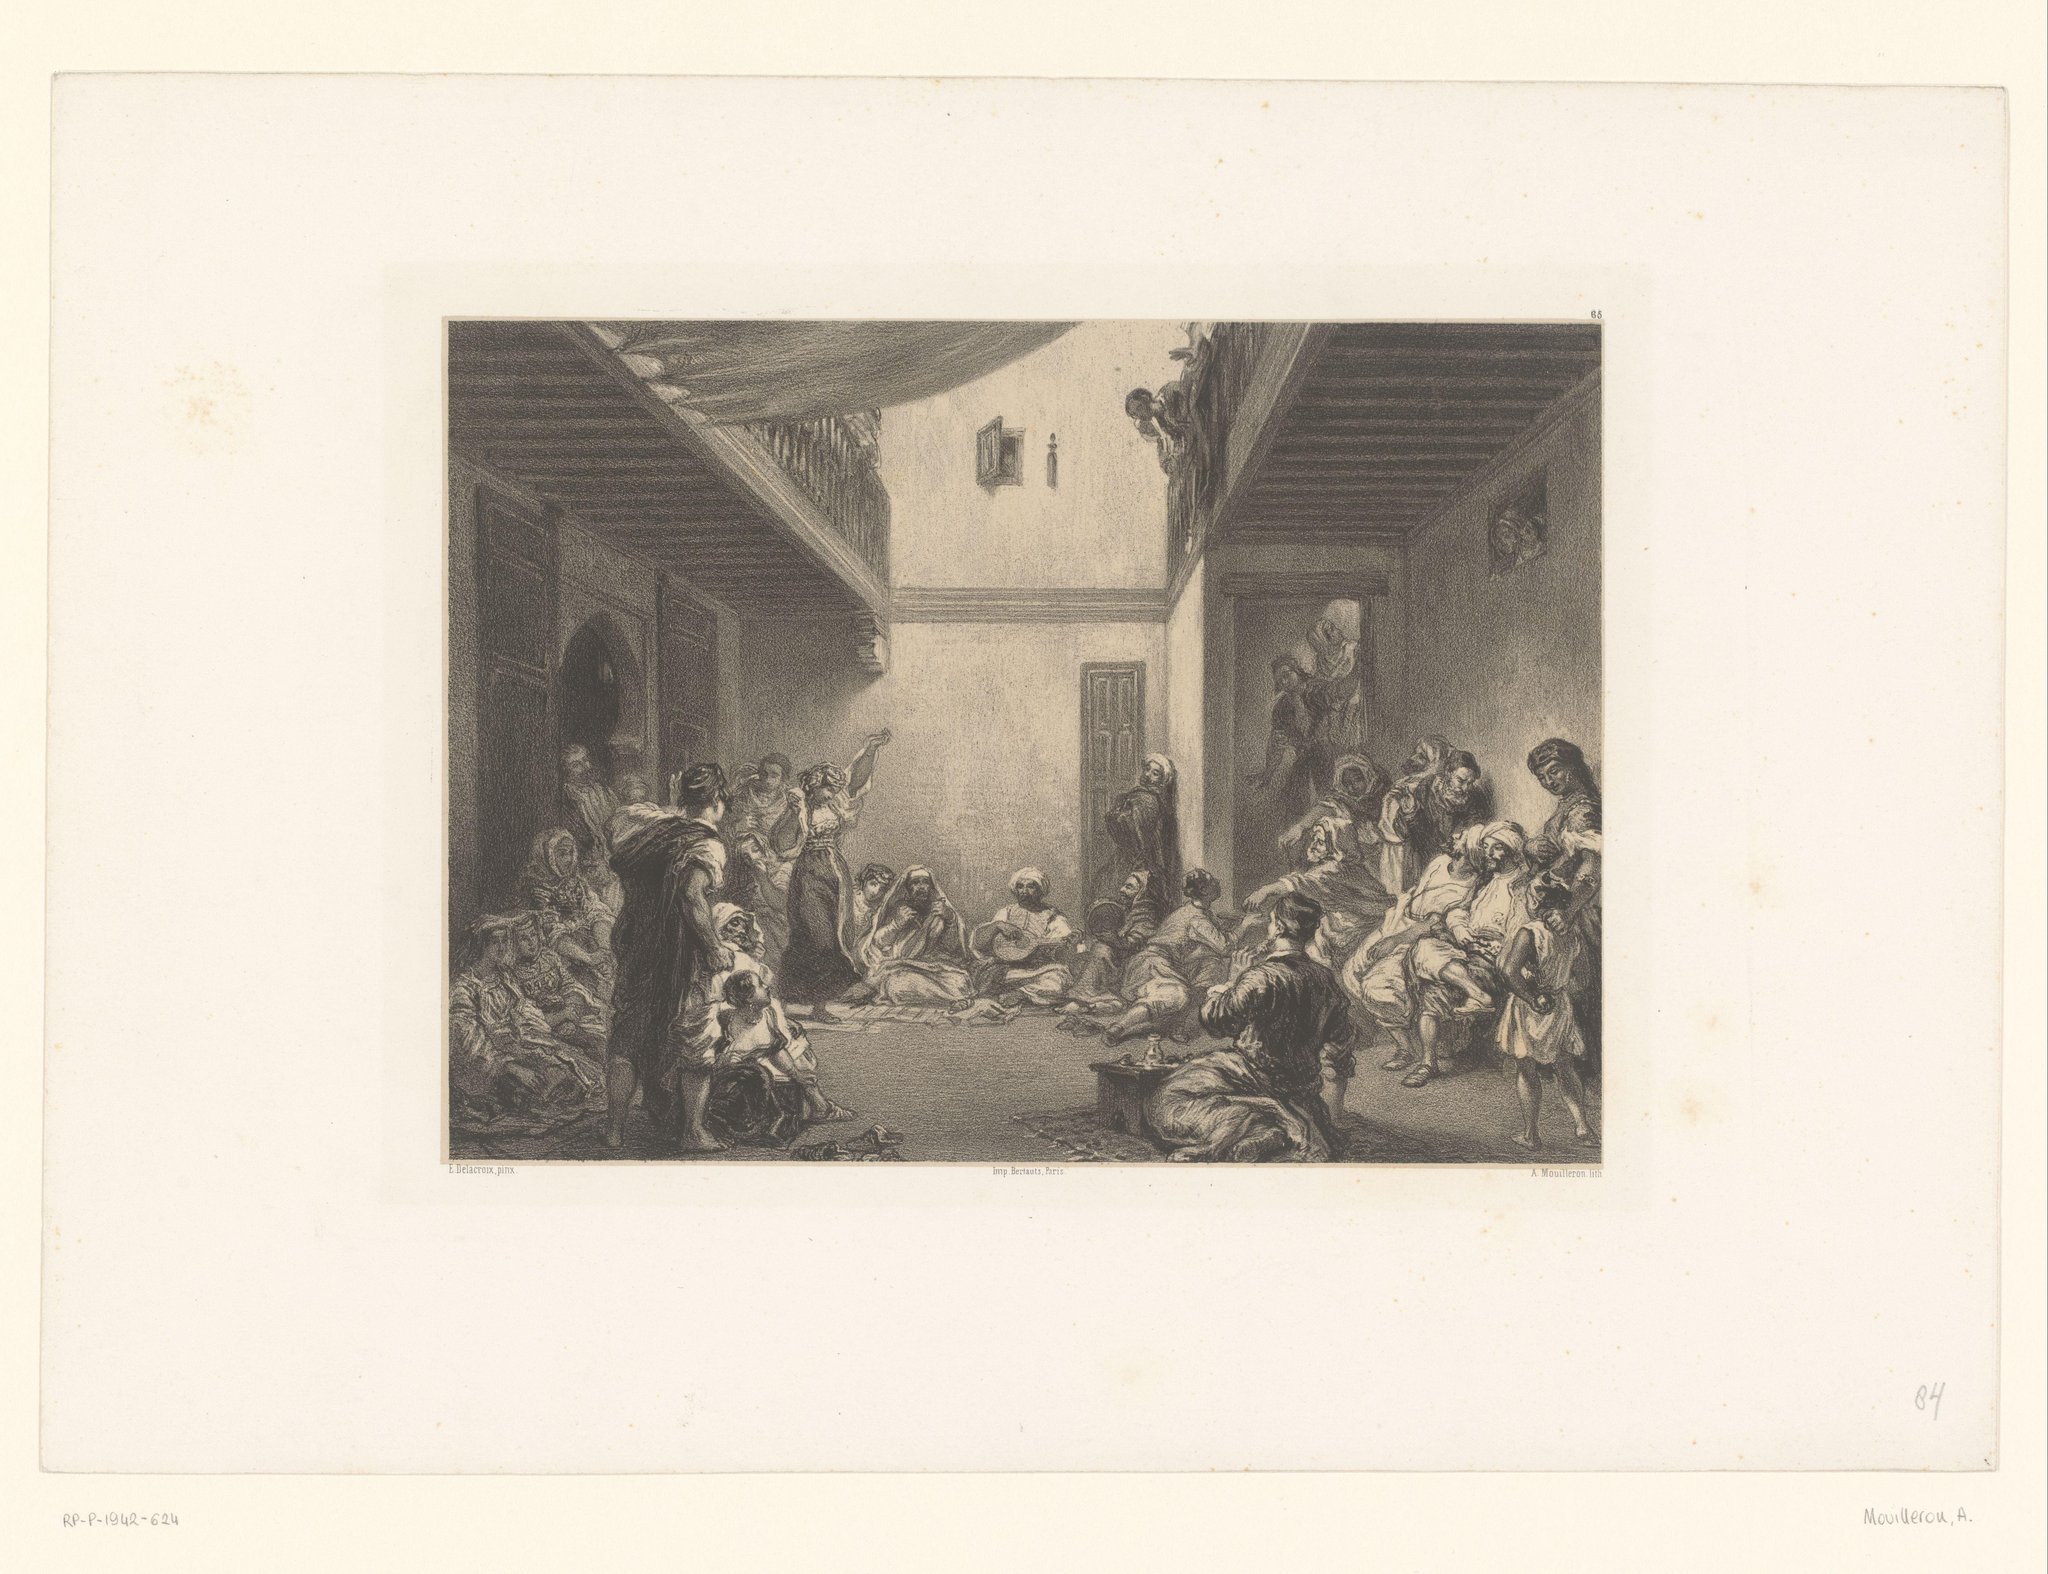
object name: print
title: Joodse bruiloft in Marokko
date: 1846-1853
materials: paper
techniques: tone lithography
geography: paris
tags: wedding feast, wedding meal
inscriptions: collector's mark: Lugt 2228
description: Binnenplaats met zittende mannen met tulbanden en een dansende vrouw.